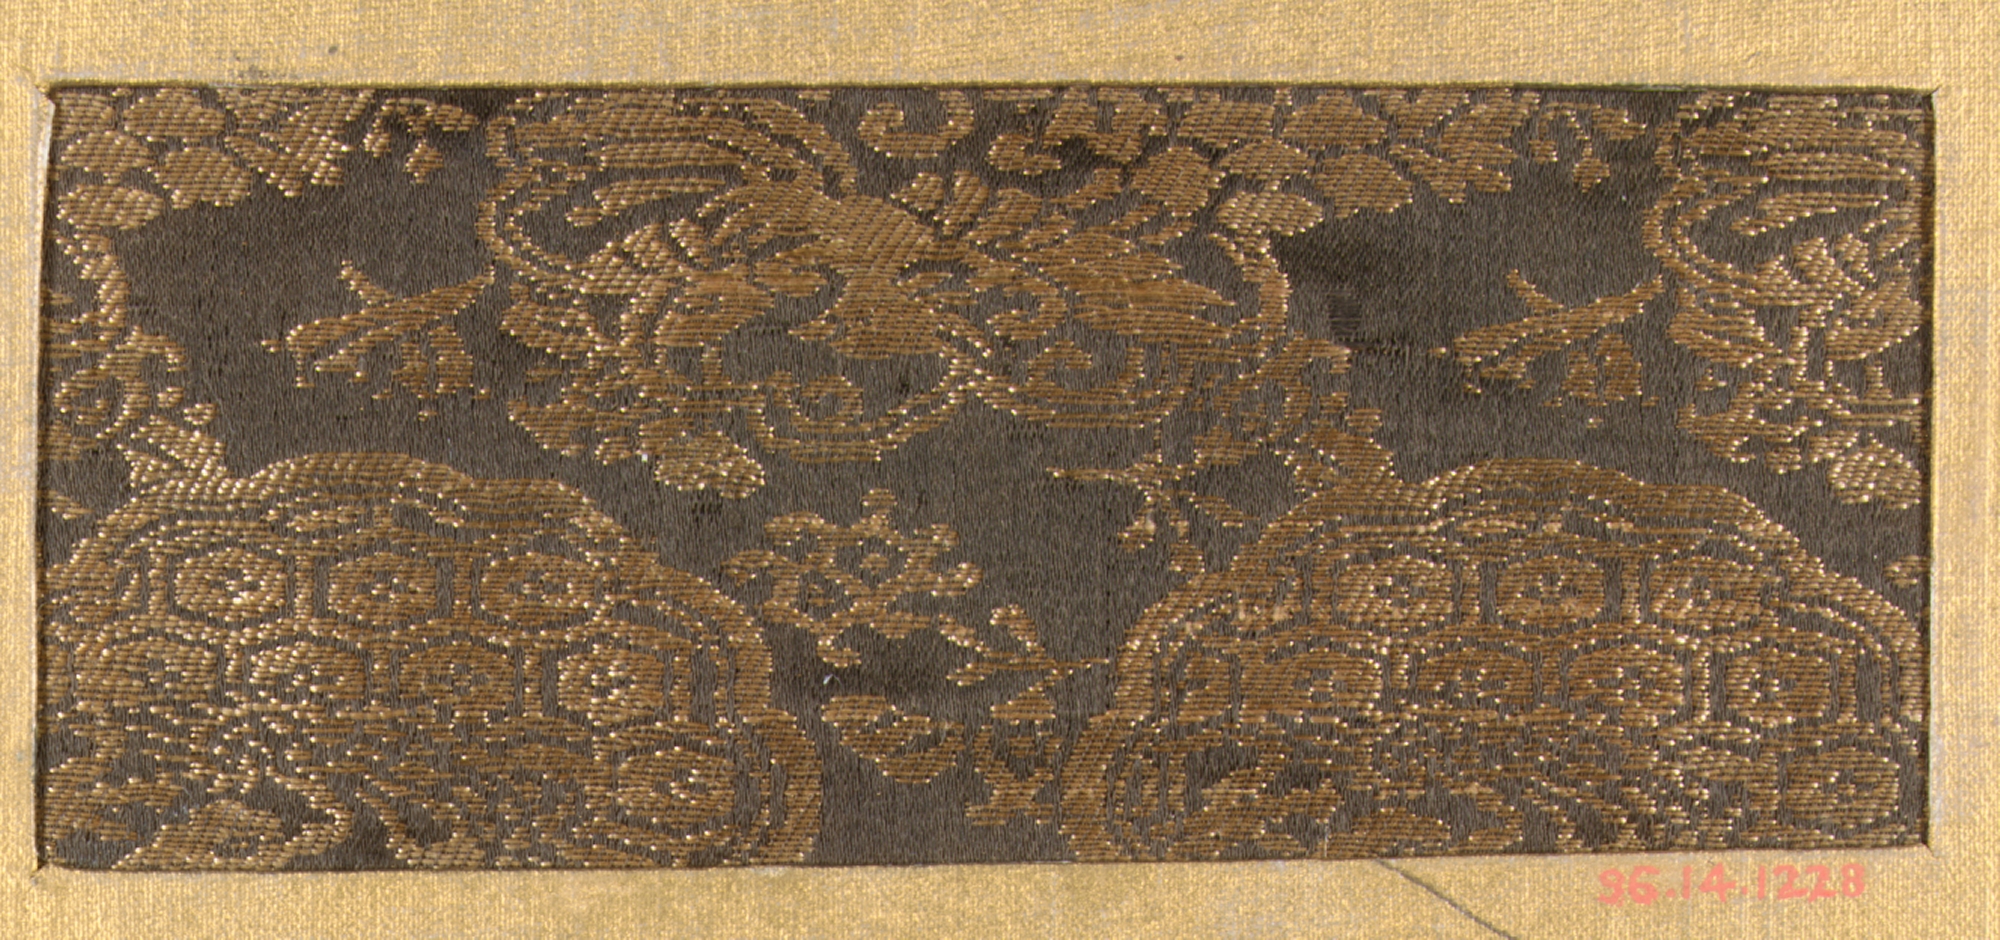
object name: piece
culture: japanese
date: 1701-1900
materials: silk